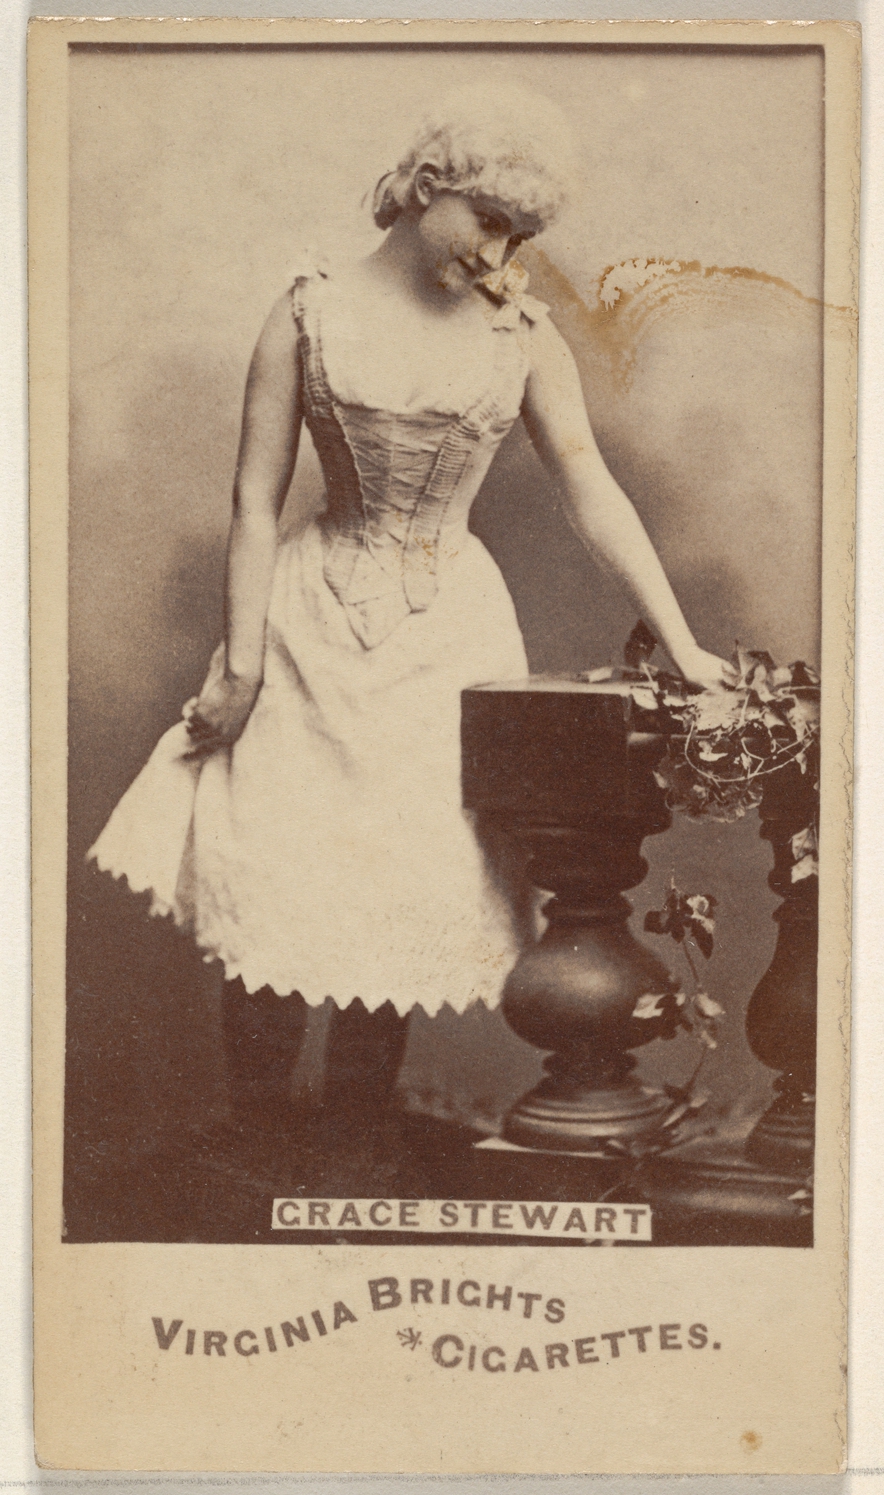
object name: photograph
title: Grace Stewart, from the Actors and Actresses series (N45, Type 6) for Virginia Brights Cigarettes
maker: allen & ginter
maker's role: publisher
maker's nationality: american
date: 1888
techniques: albumen silver print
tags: portraits,women,actresses